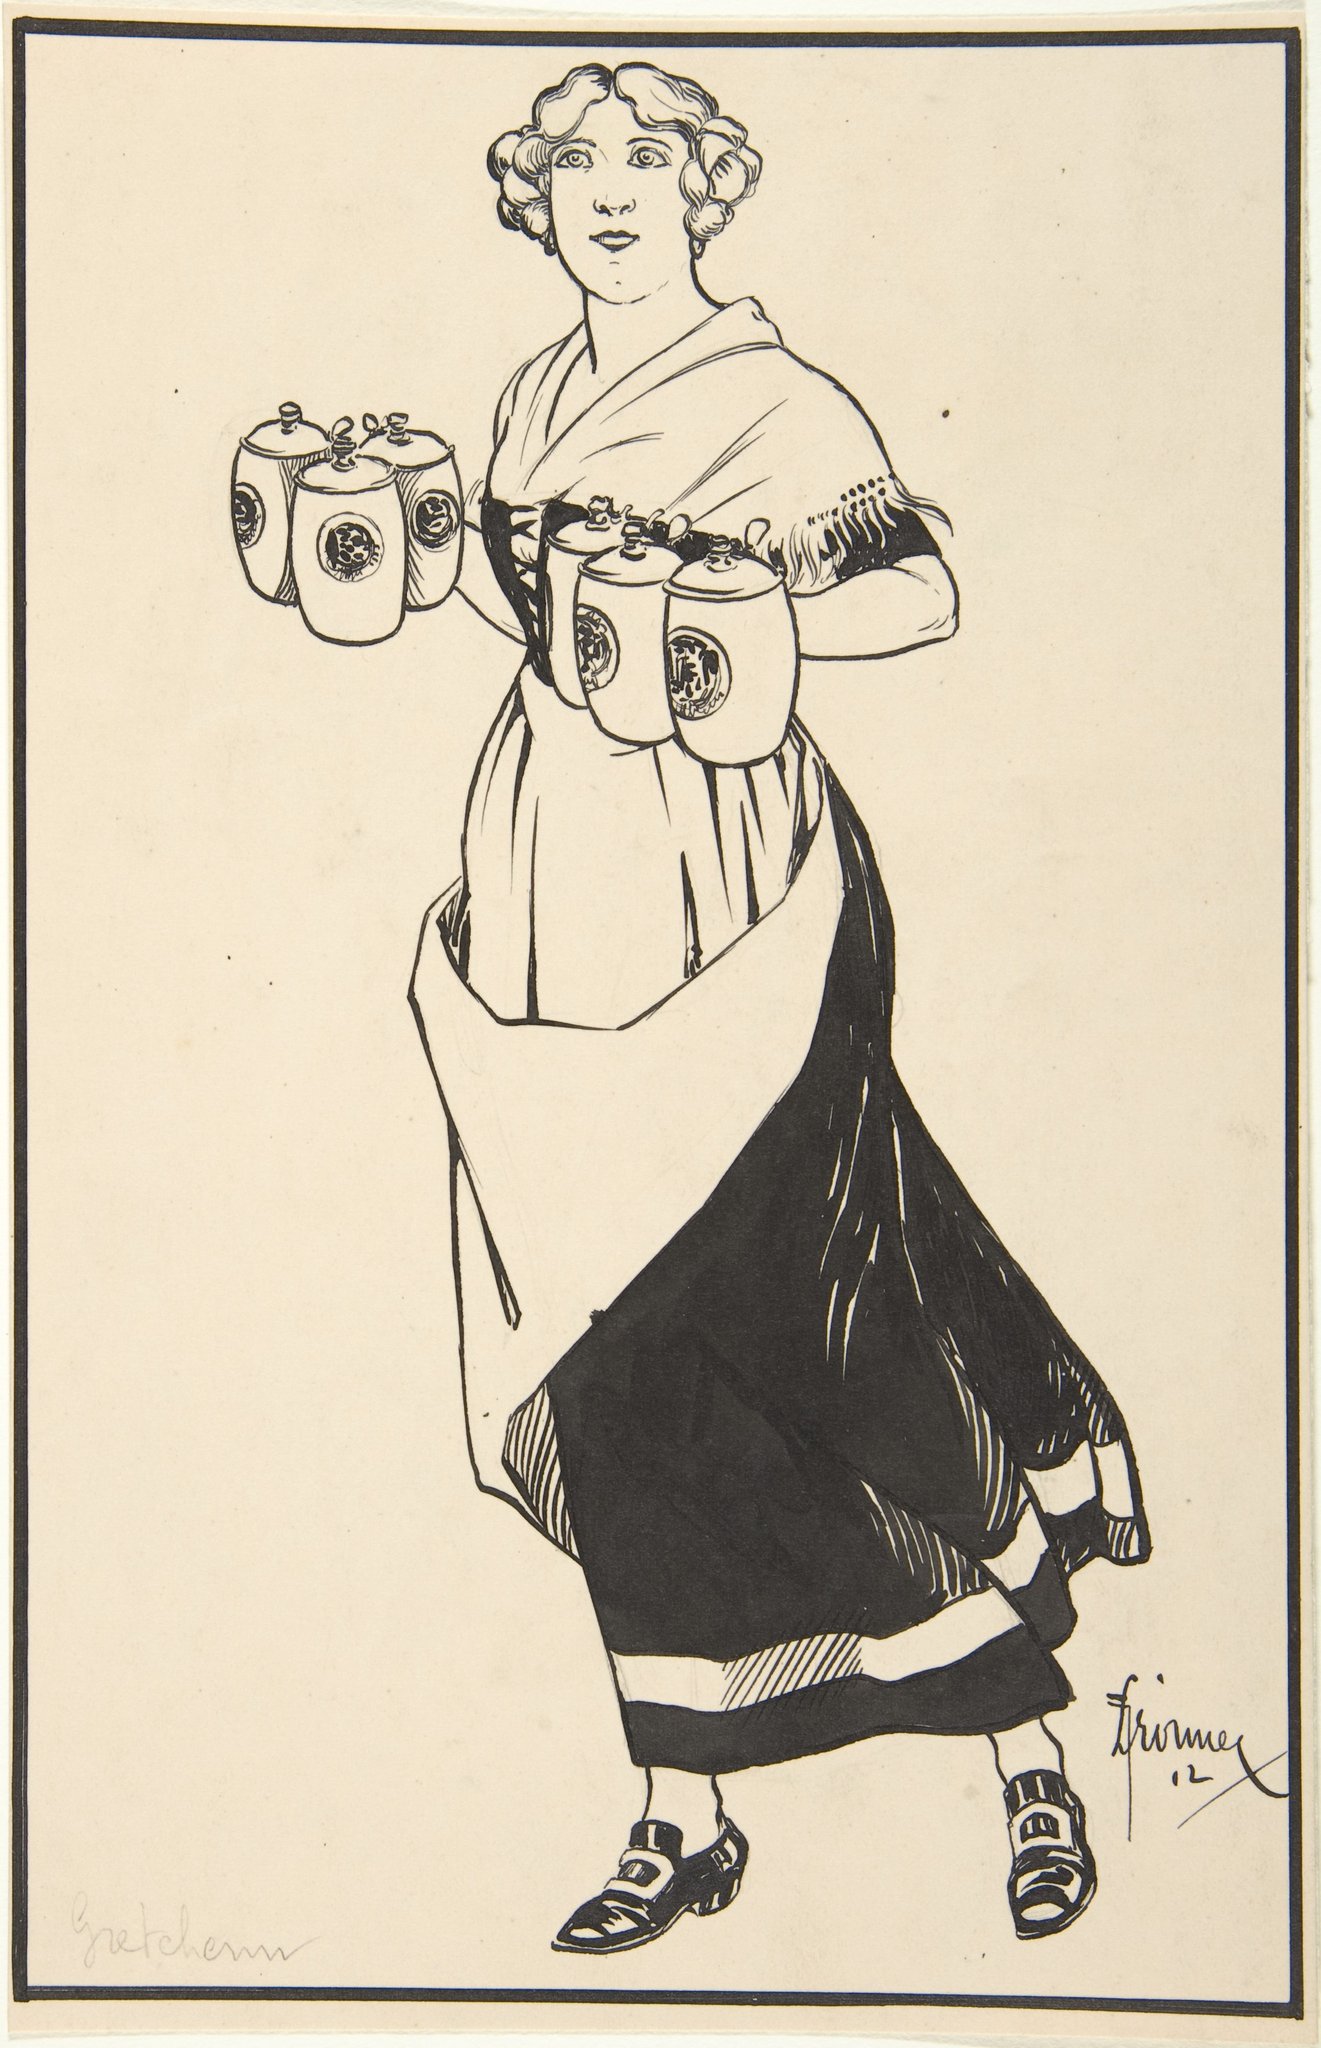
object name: drawing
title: Woman Carrying Beer Steins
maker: f. droimer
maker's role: artist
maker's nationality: german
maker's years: 1912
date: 1912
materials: ink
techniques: brush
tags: women